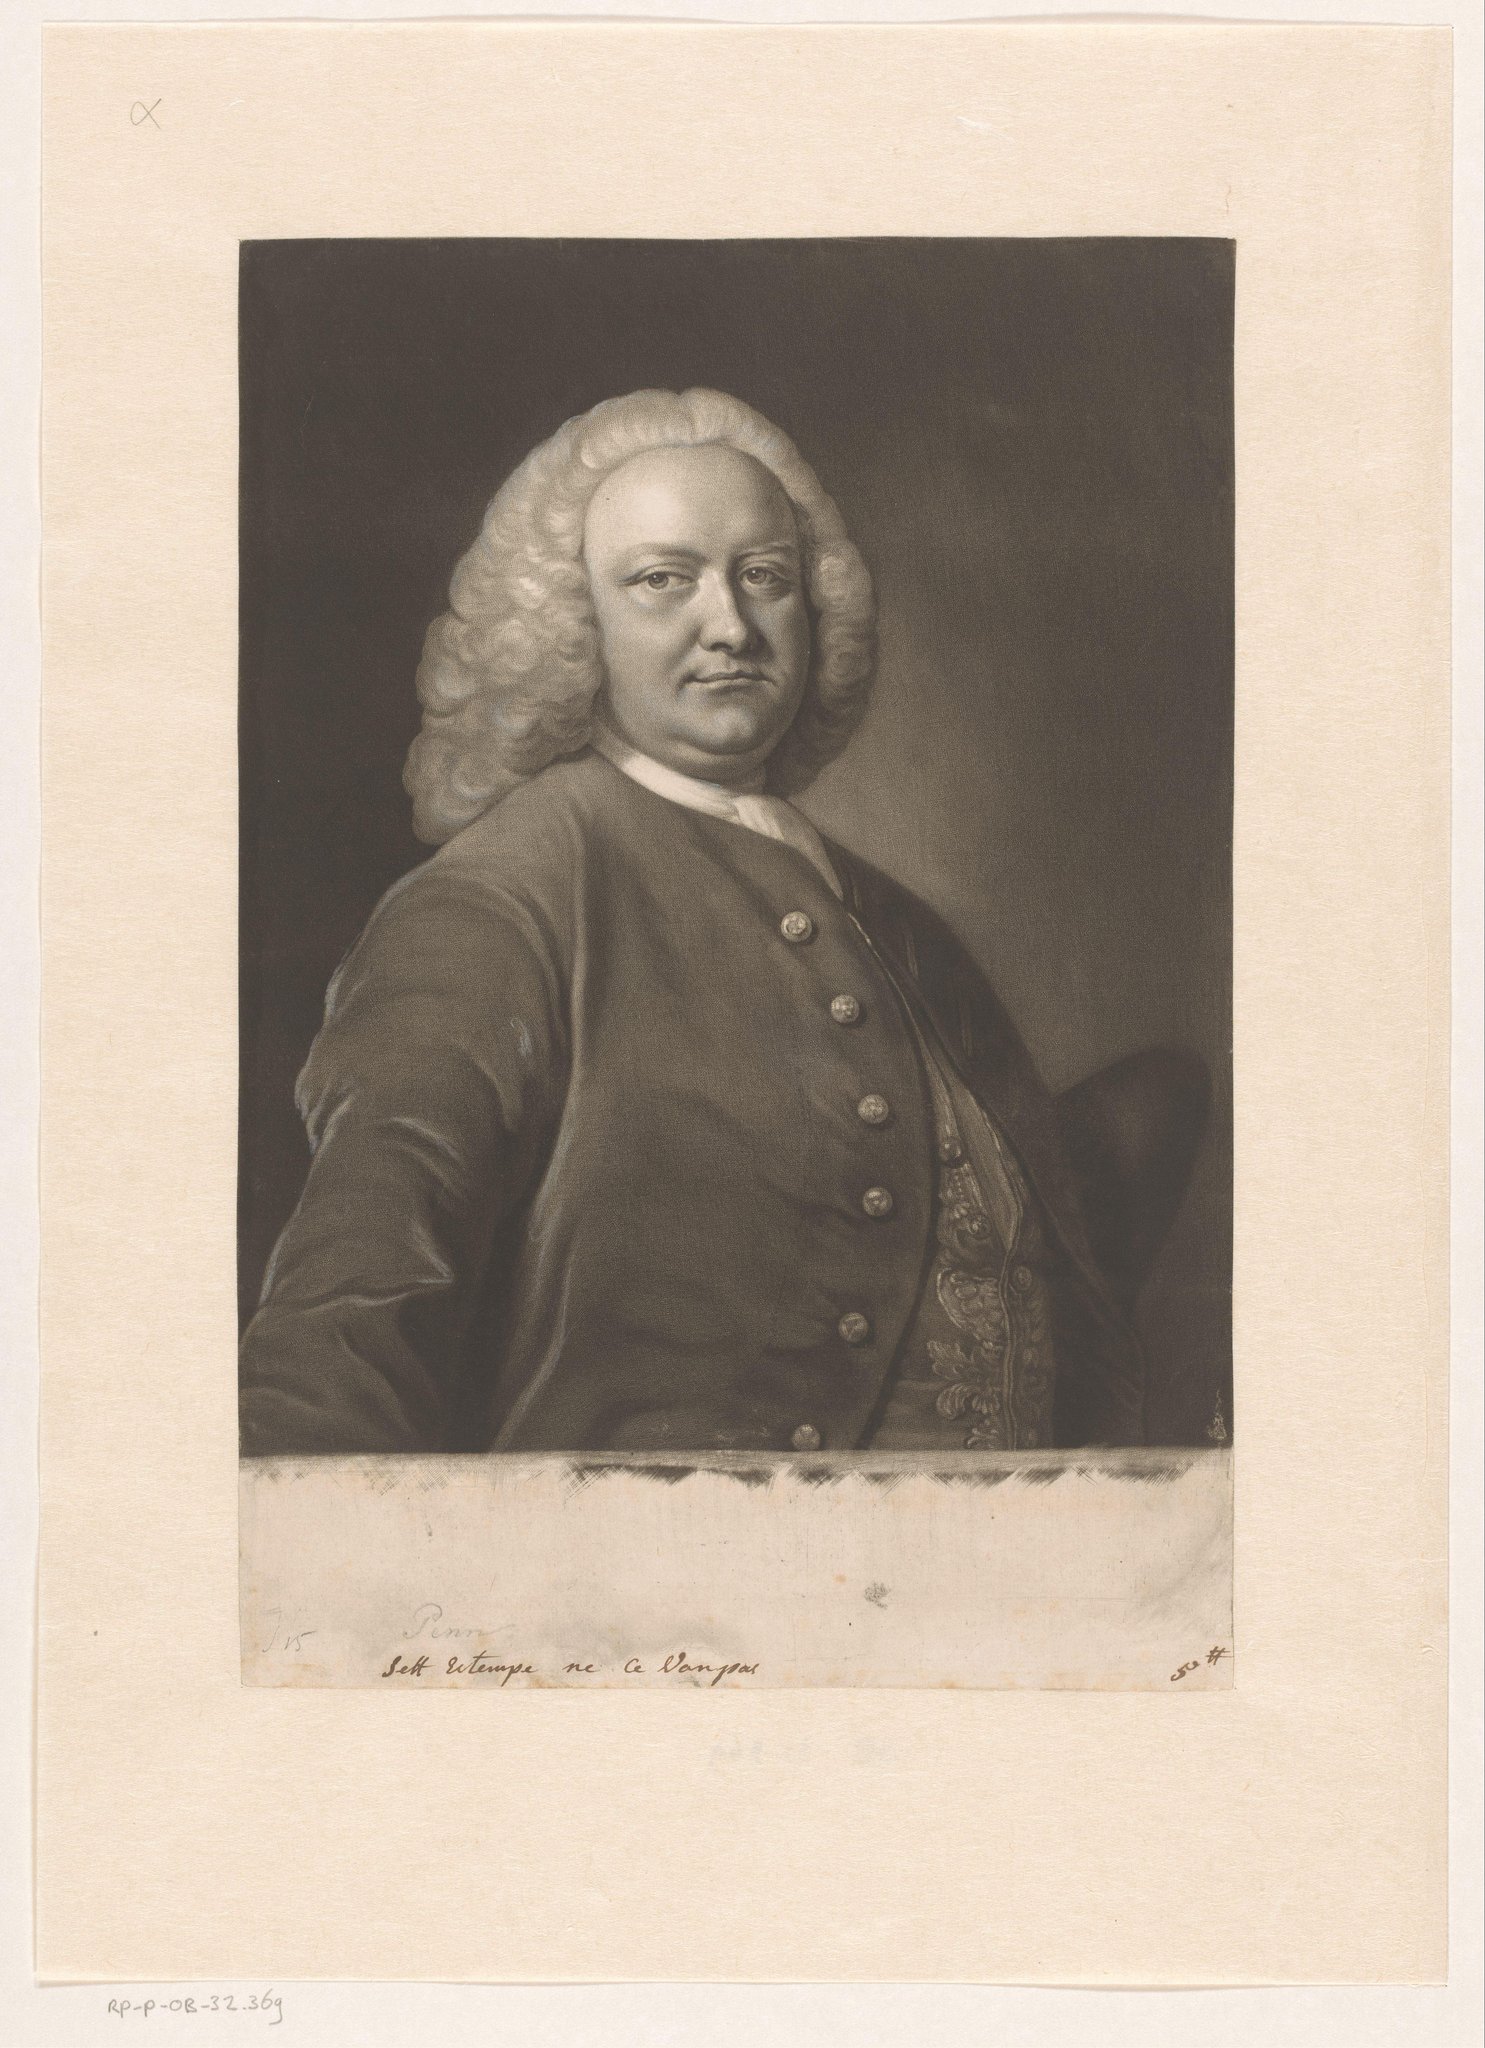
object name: print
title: Portret van William Benn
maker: james mcardell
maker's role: print maker, publisher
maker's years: 1728-1765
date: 1746-1765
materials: paint, paper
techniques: mezzotint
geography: london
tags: politician, mayor, burgomaster, historical persons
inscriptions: collector's mark: Lugt 240